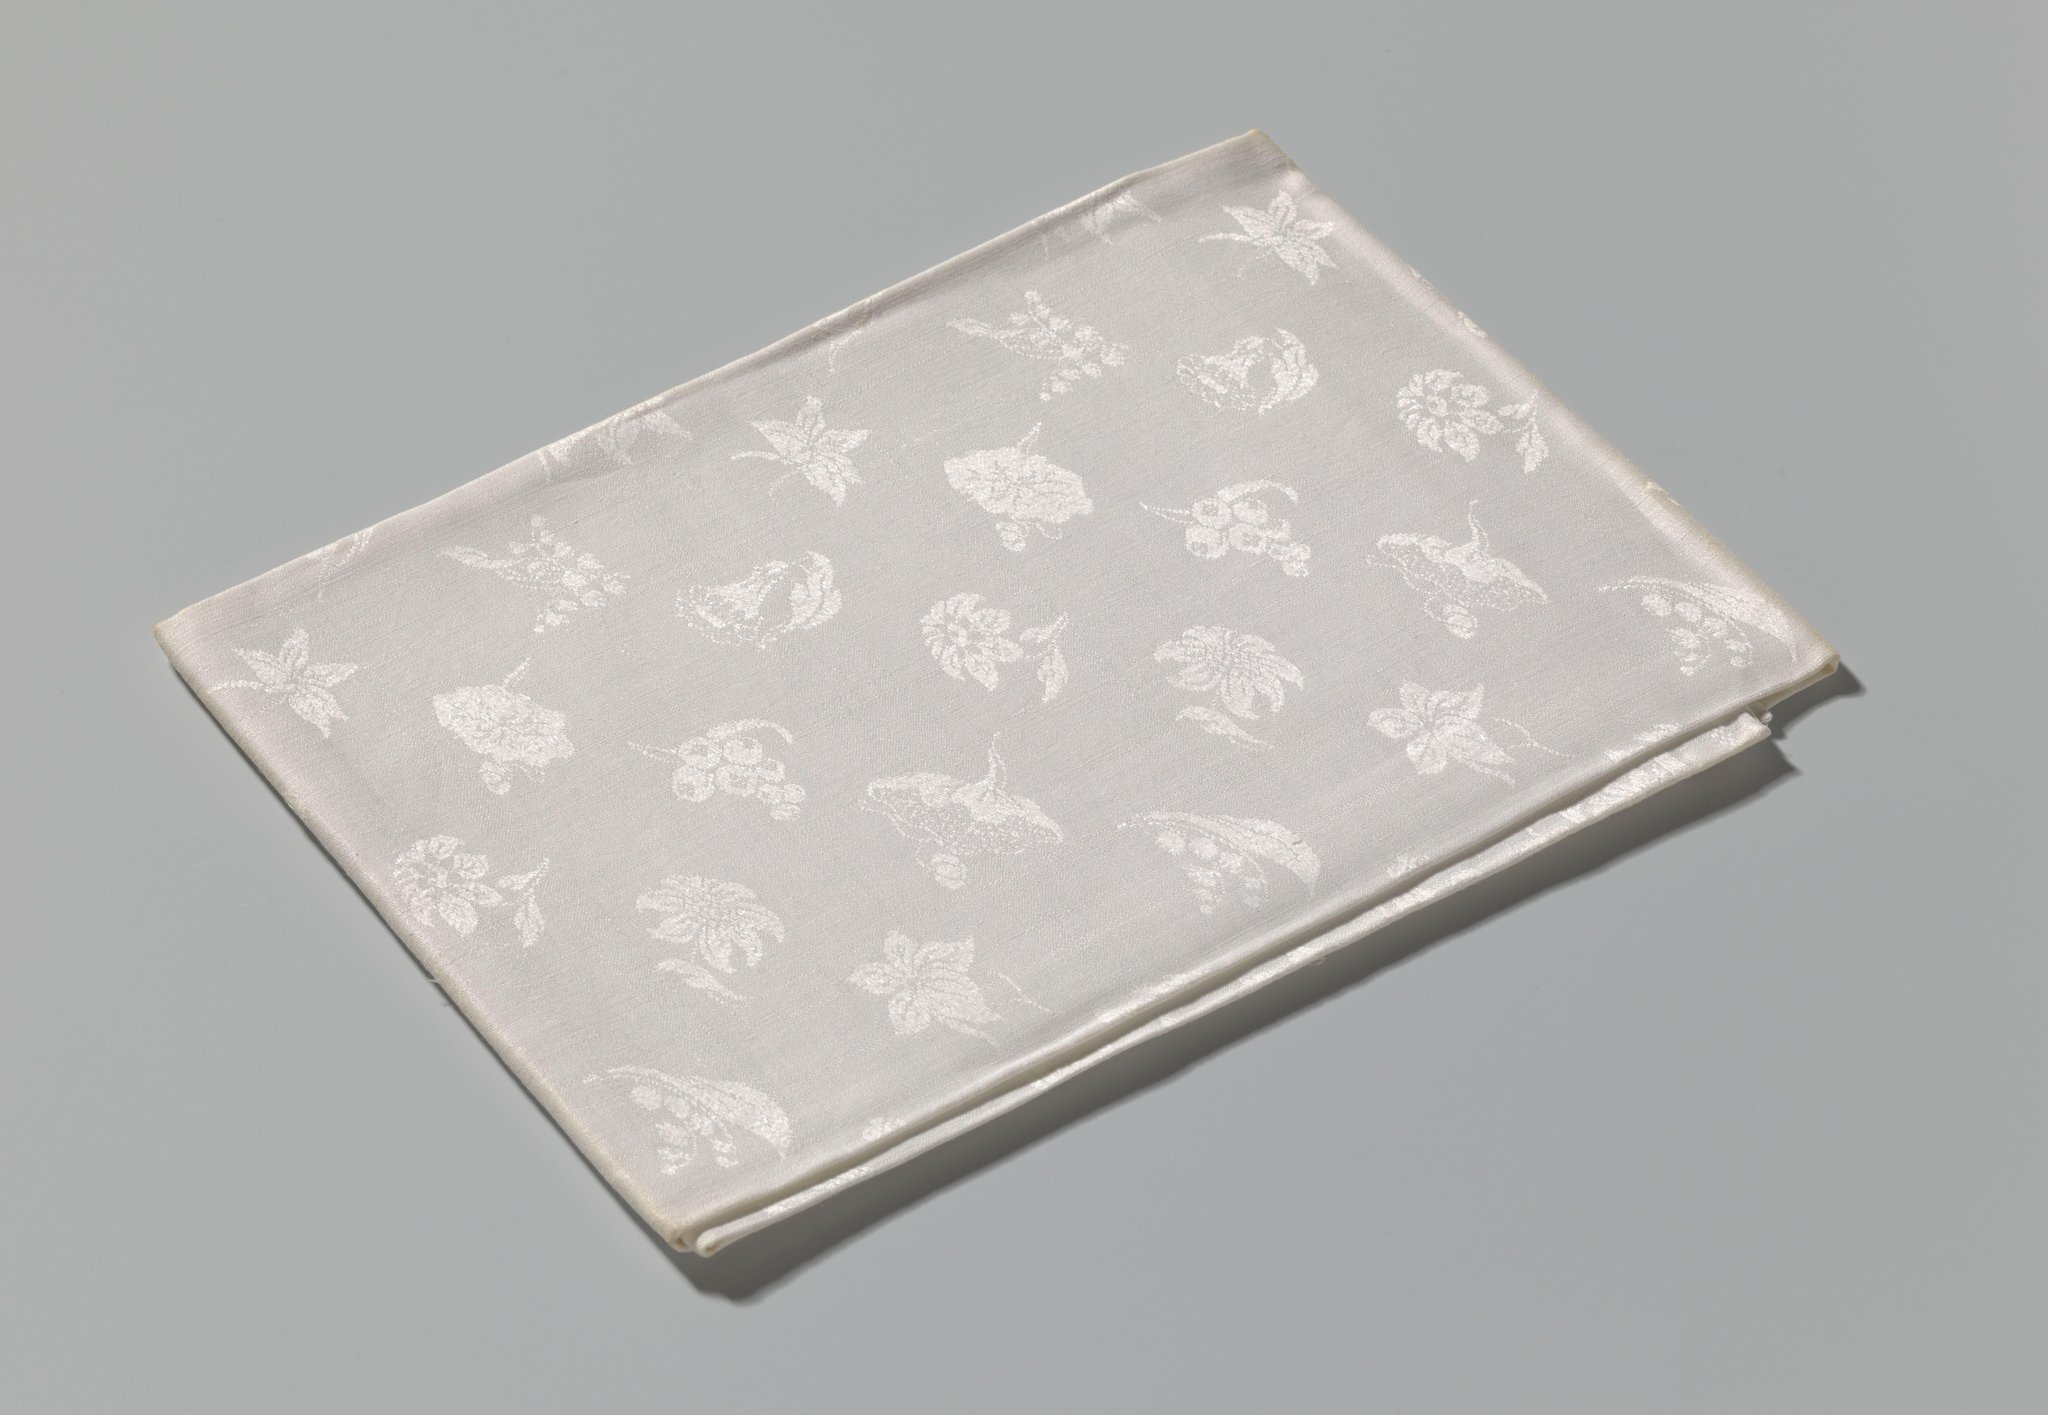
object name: napkin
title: Servet van wit linnendamast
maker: Anonymous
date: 1800-1900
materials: linen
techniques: damask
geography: netherlands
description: Wit linnen damasten servet met gestrooide bloempjes en bloemenrand.